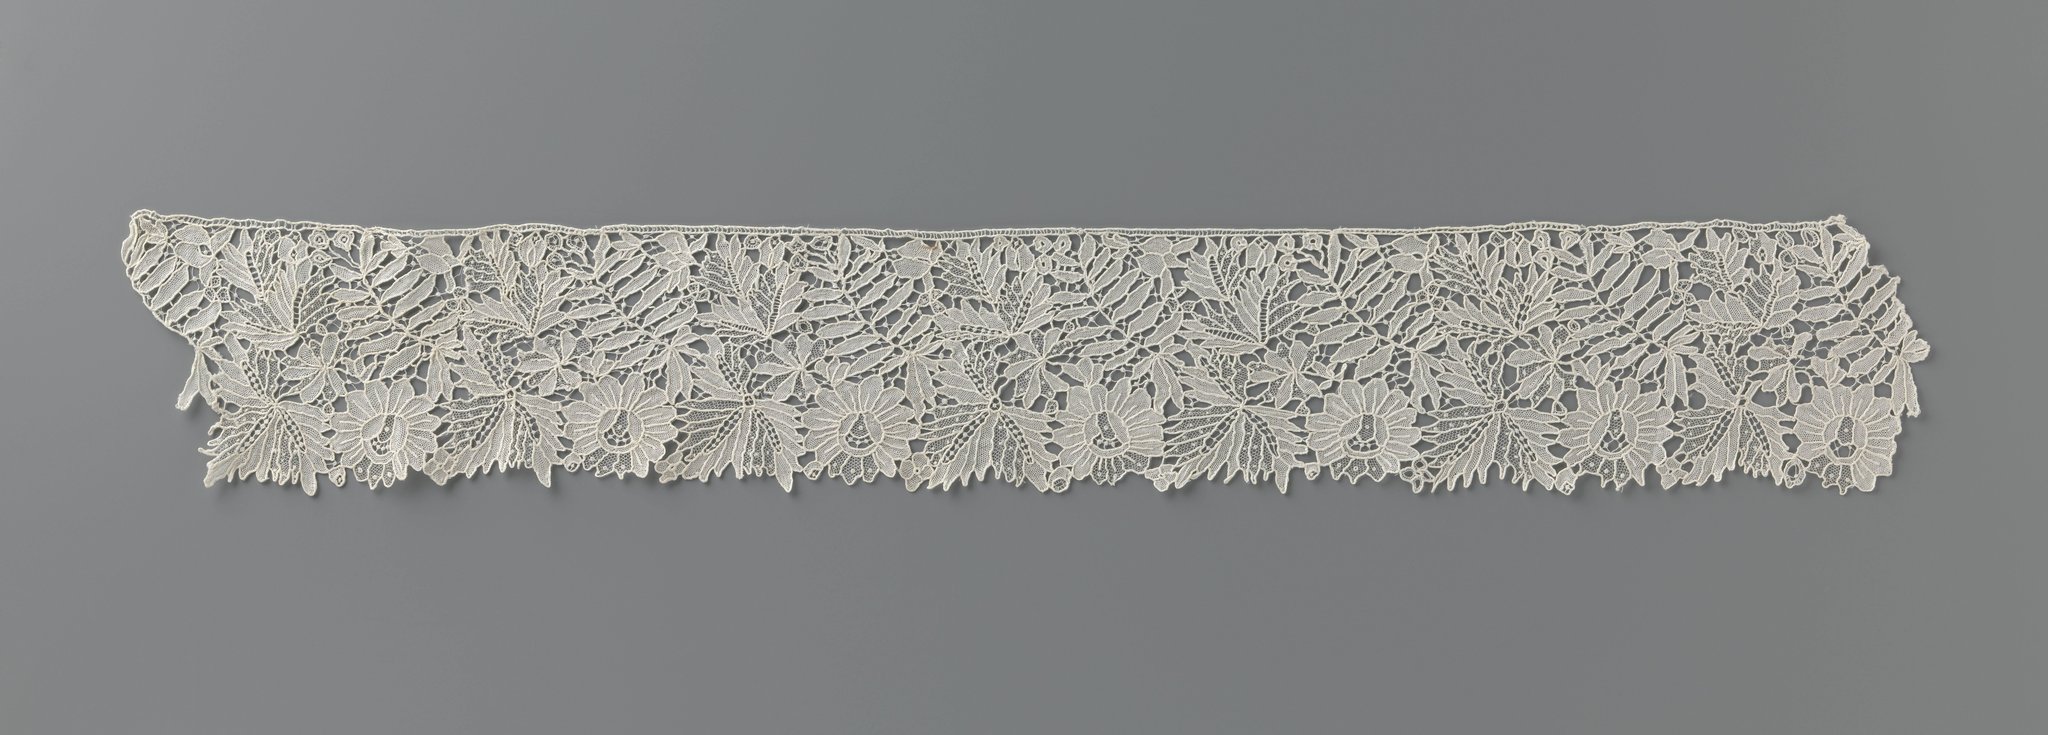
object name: strip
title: Strook naaldkant met ingesneden blad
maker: Anonymous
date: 1900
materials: linen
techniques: needle lace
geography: karlsbad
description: Lopend patroon van ingesneden bladeren boven een roos en een drieblad, die samen de scherp getande buitenlijn vormen. Kruisvormige spijlen met knoopje (grond van lange X-vormige spijlen met een spin). Het remplis bestaat uit knoopsgatensteken en een fond gazé. Duitse kant: 'Carlsbader Points'.